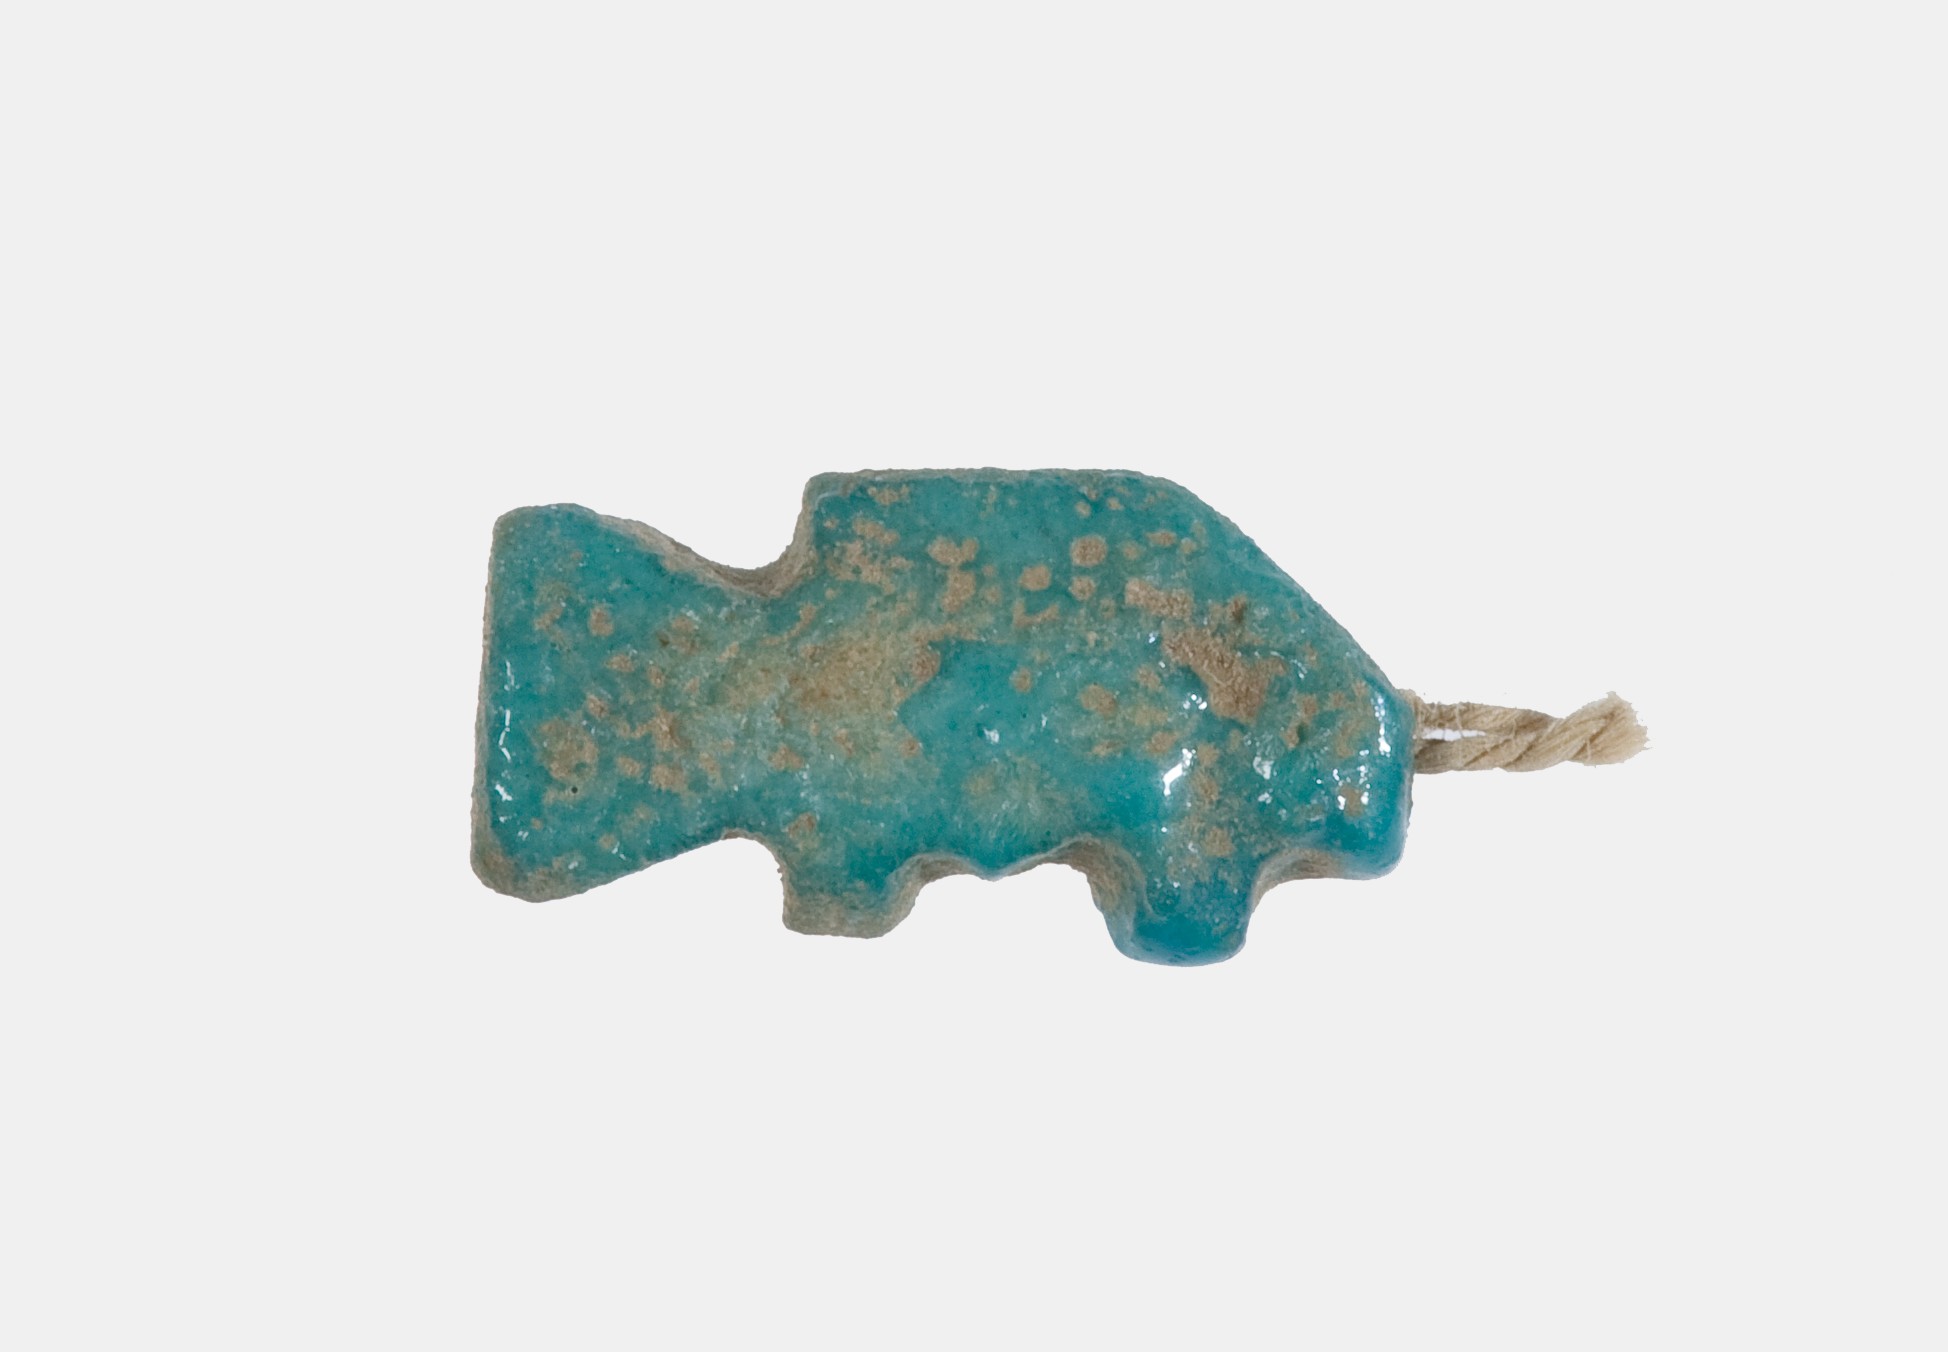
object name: amulet, fish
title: Fish Amulet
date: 1802-1450 BCE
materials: faience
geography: egypt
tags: fish